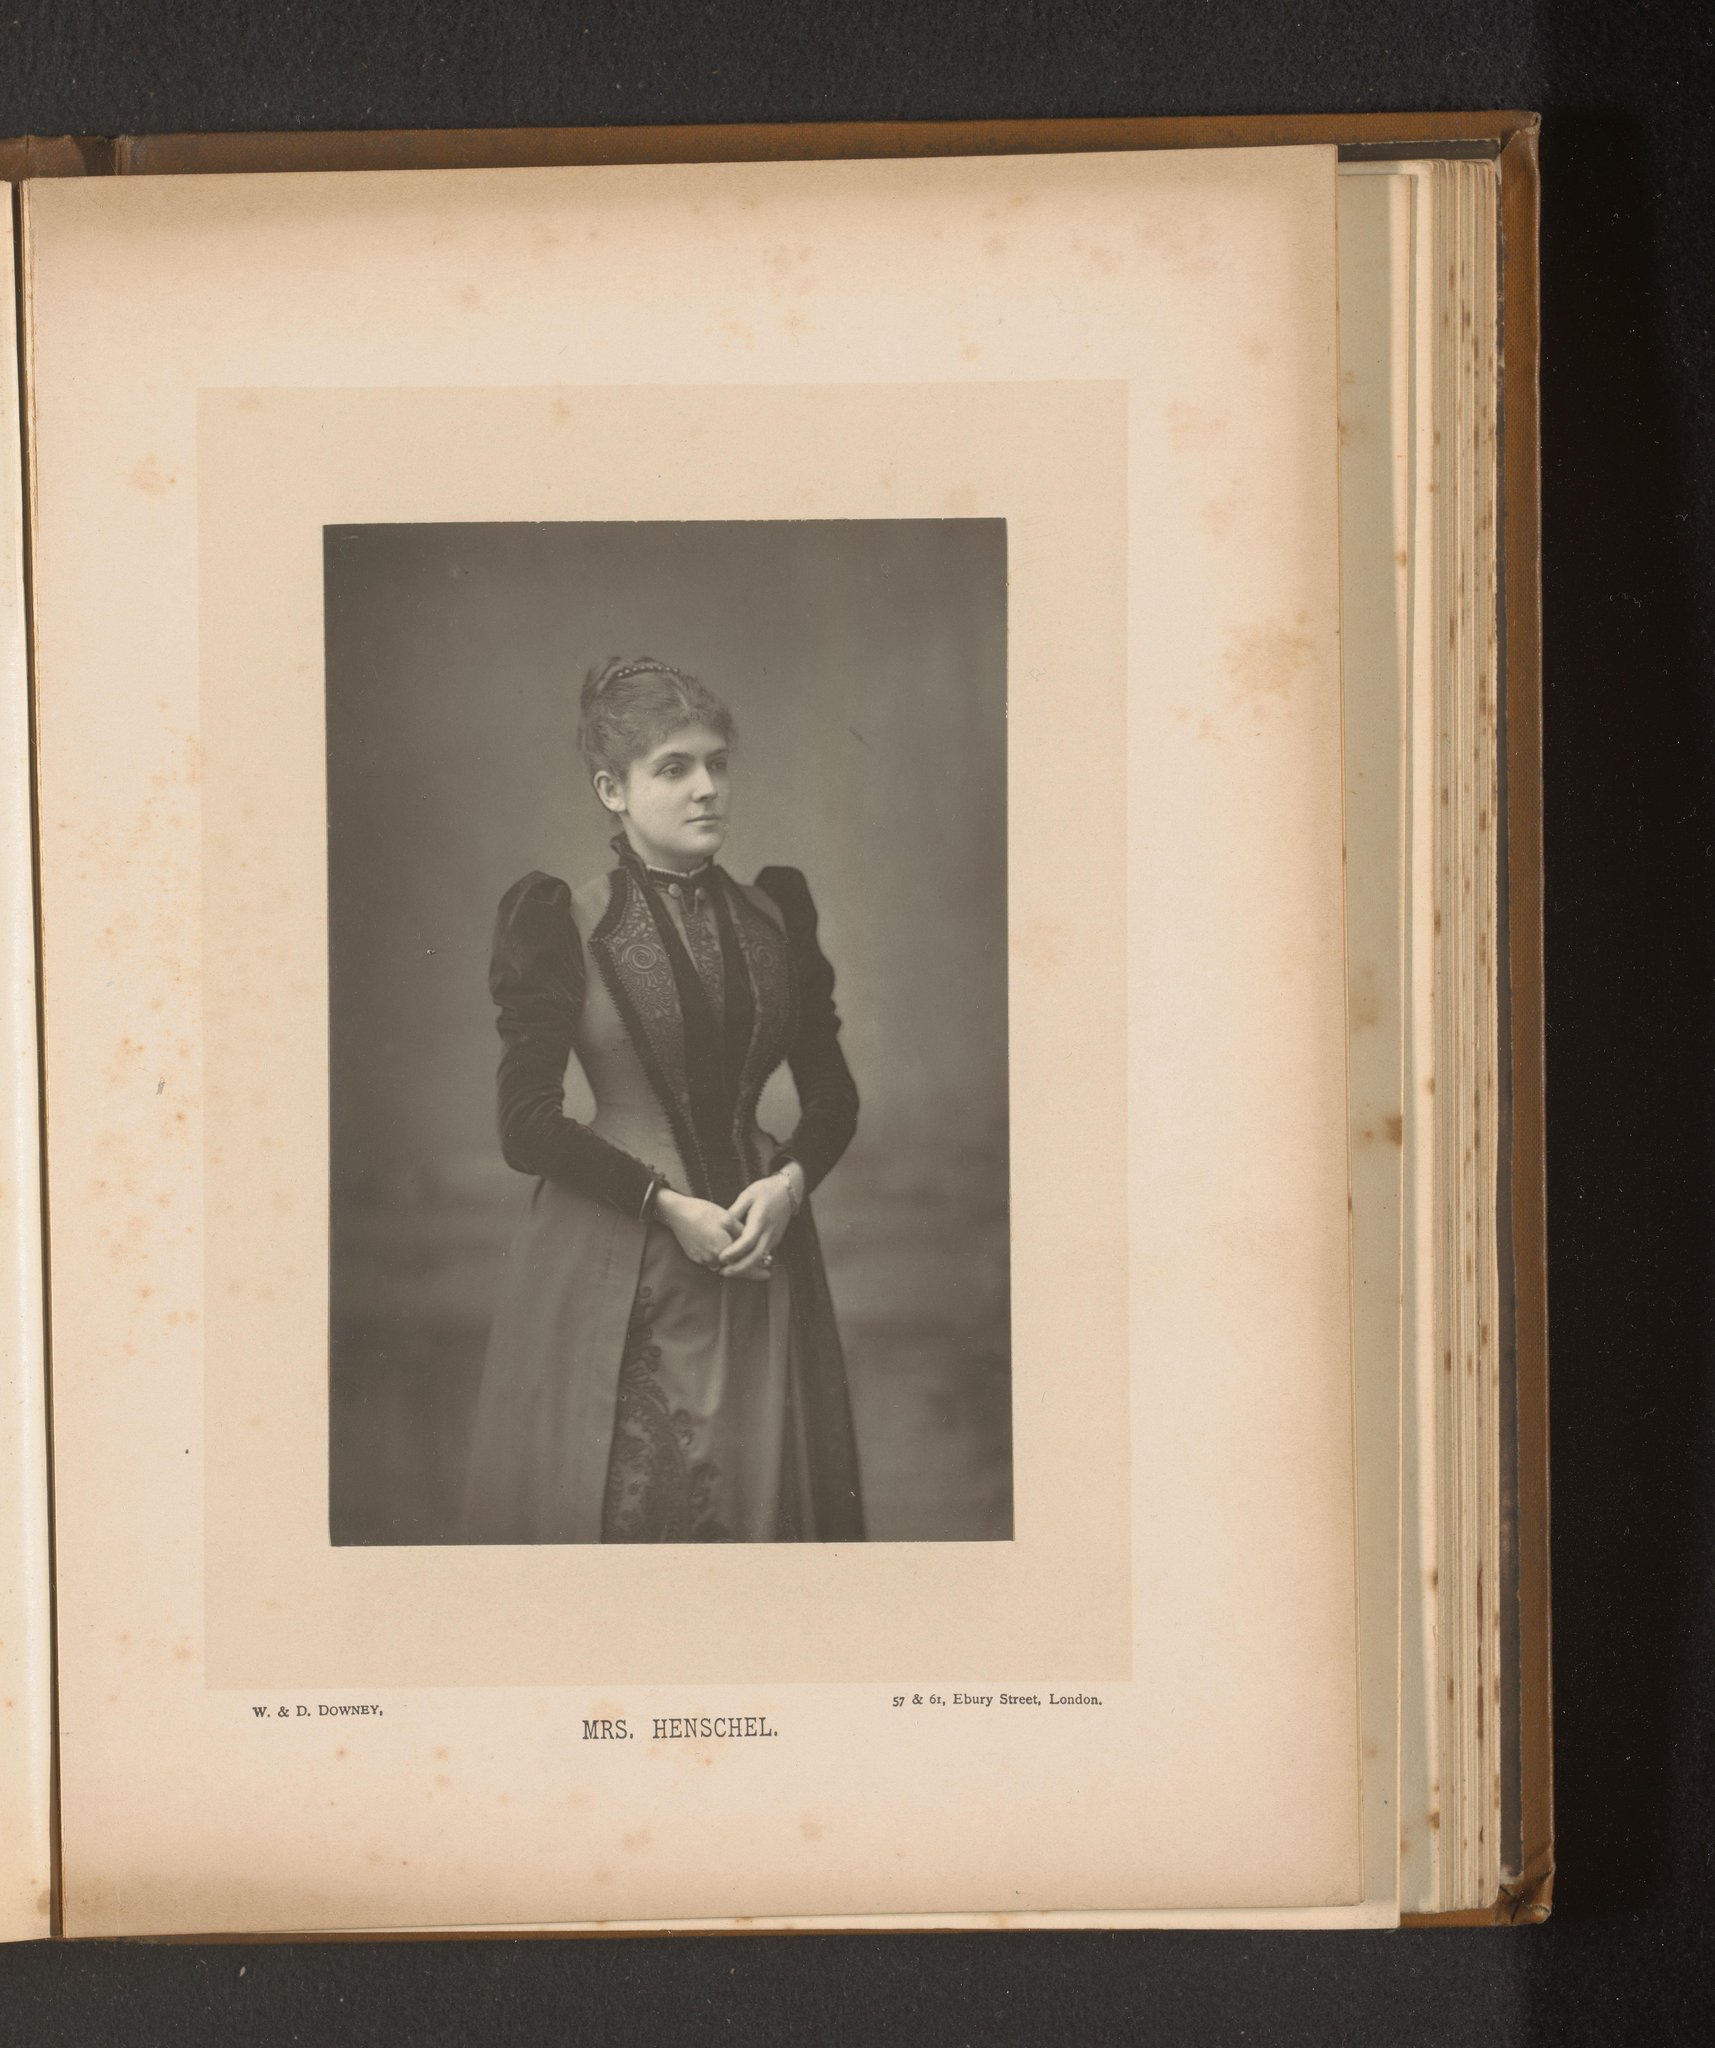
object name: photomechanical print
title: Mrs. Henschel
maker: Anonymous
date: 1881-1891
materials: paper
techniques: woodburytype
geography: london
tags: female singer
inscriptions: inscription: ‘57 & 61, Elbury Street, London.’